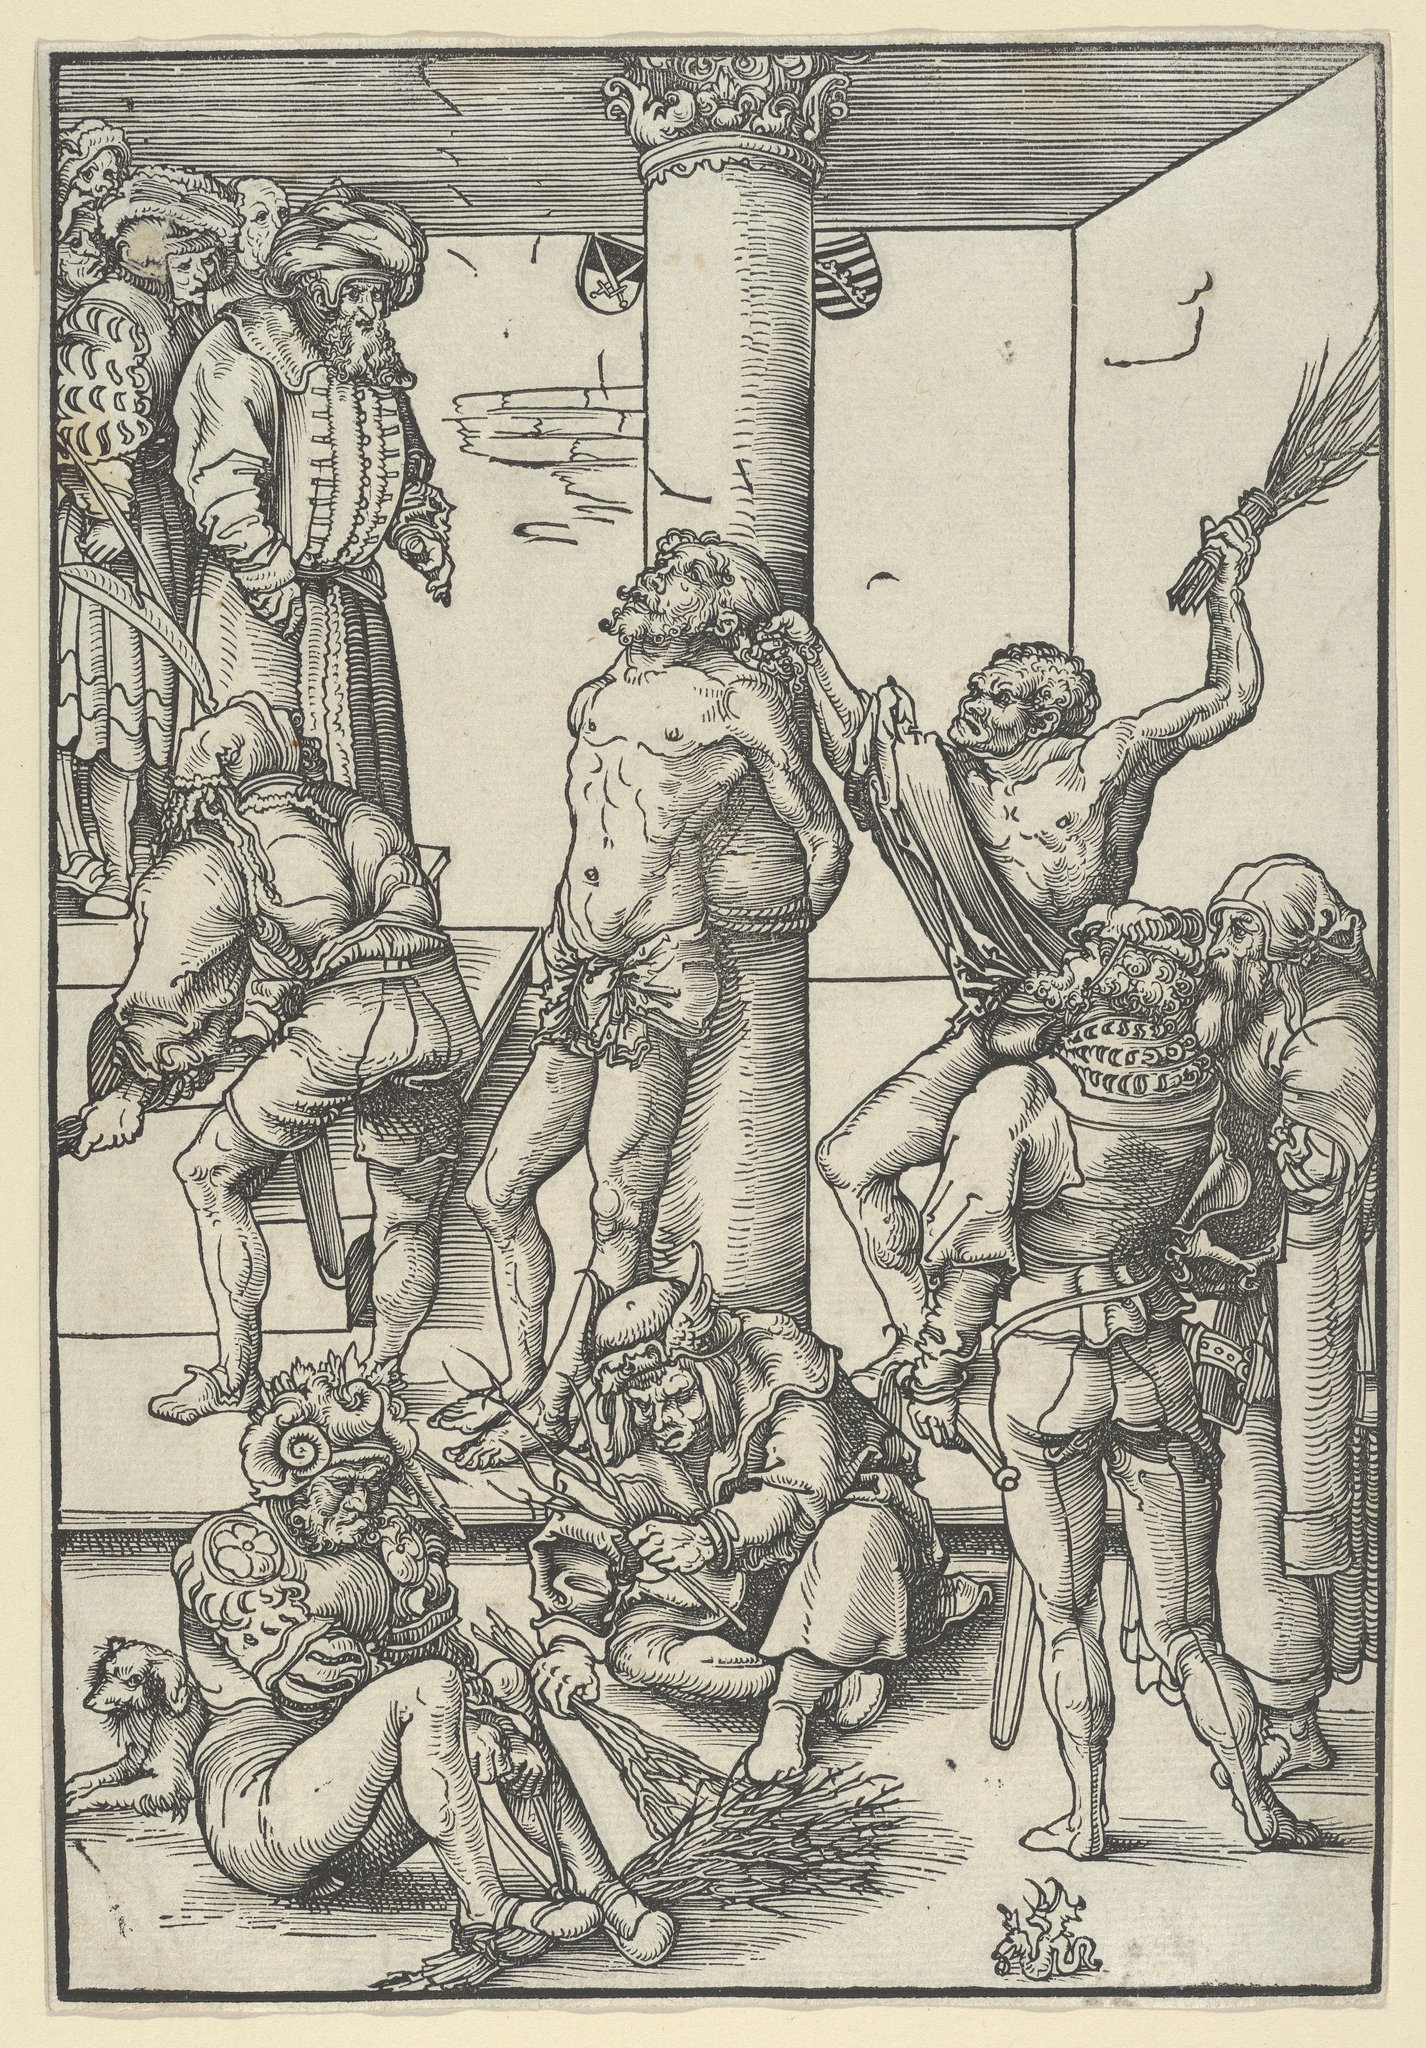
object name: print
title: The Flagellation, from The Passion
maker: lucas cranach the elder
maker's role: artist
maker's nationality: german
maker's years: 1472-1553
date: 1472-1553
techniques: woodcut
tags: men,christ,punishment